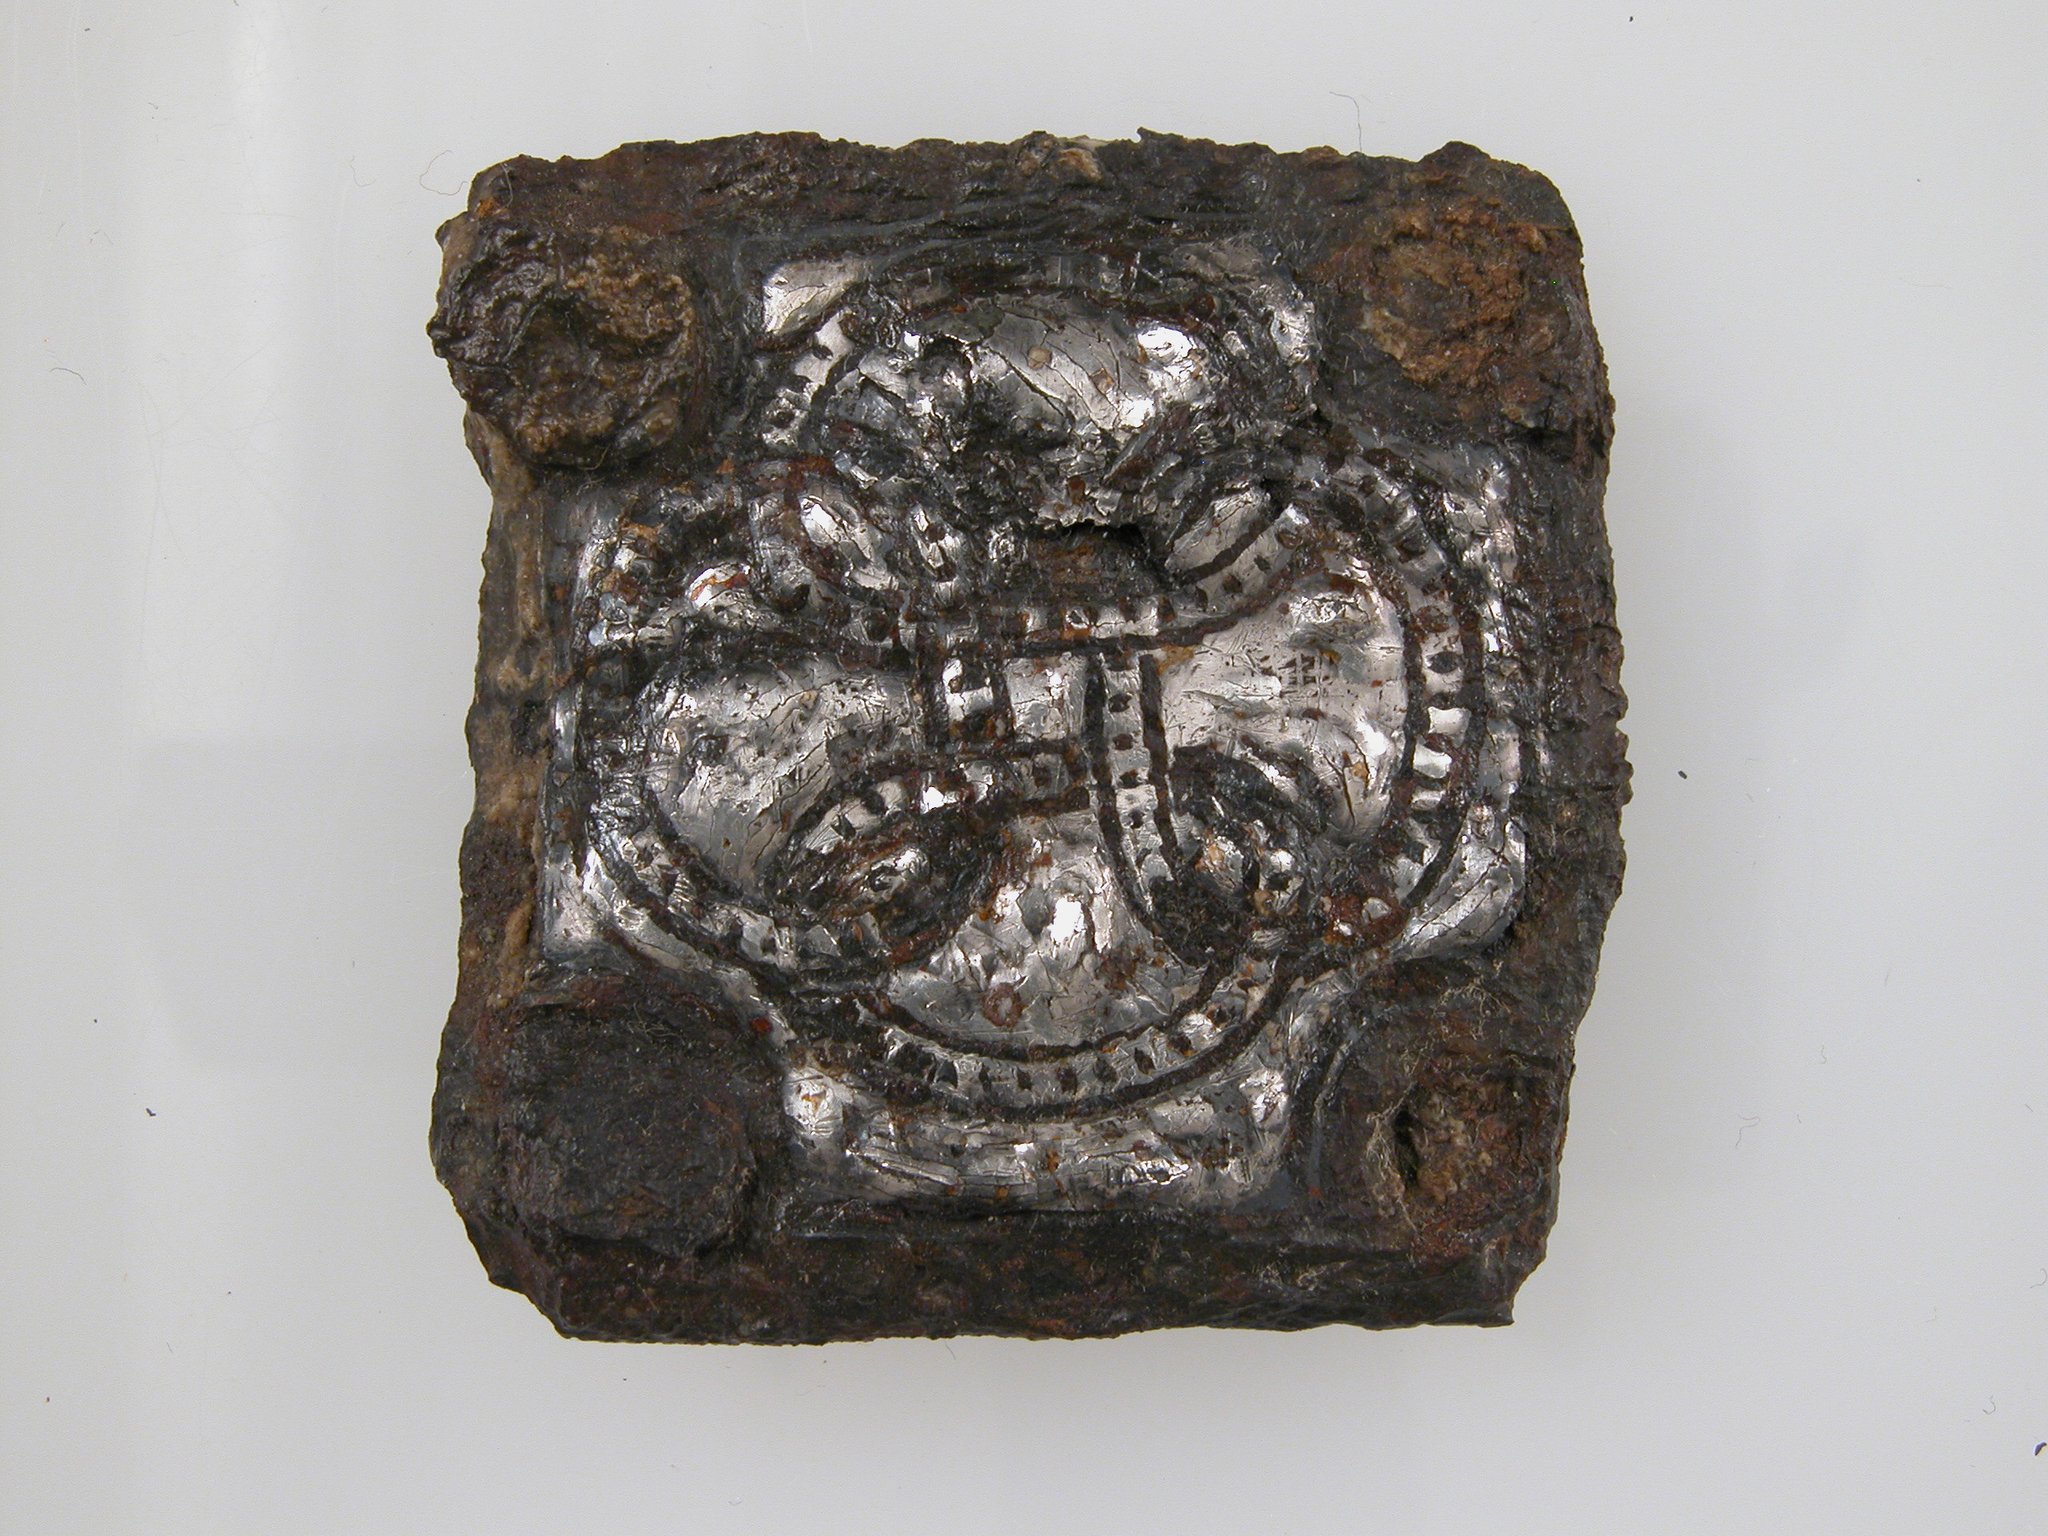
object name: belt plate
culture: frankish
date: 501-700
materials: iron, silver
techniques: inlay